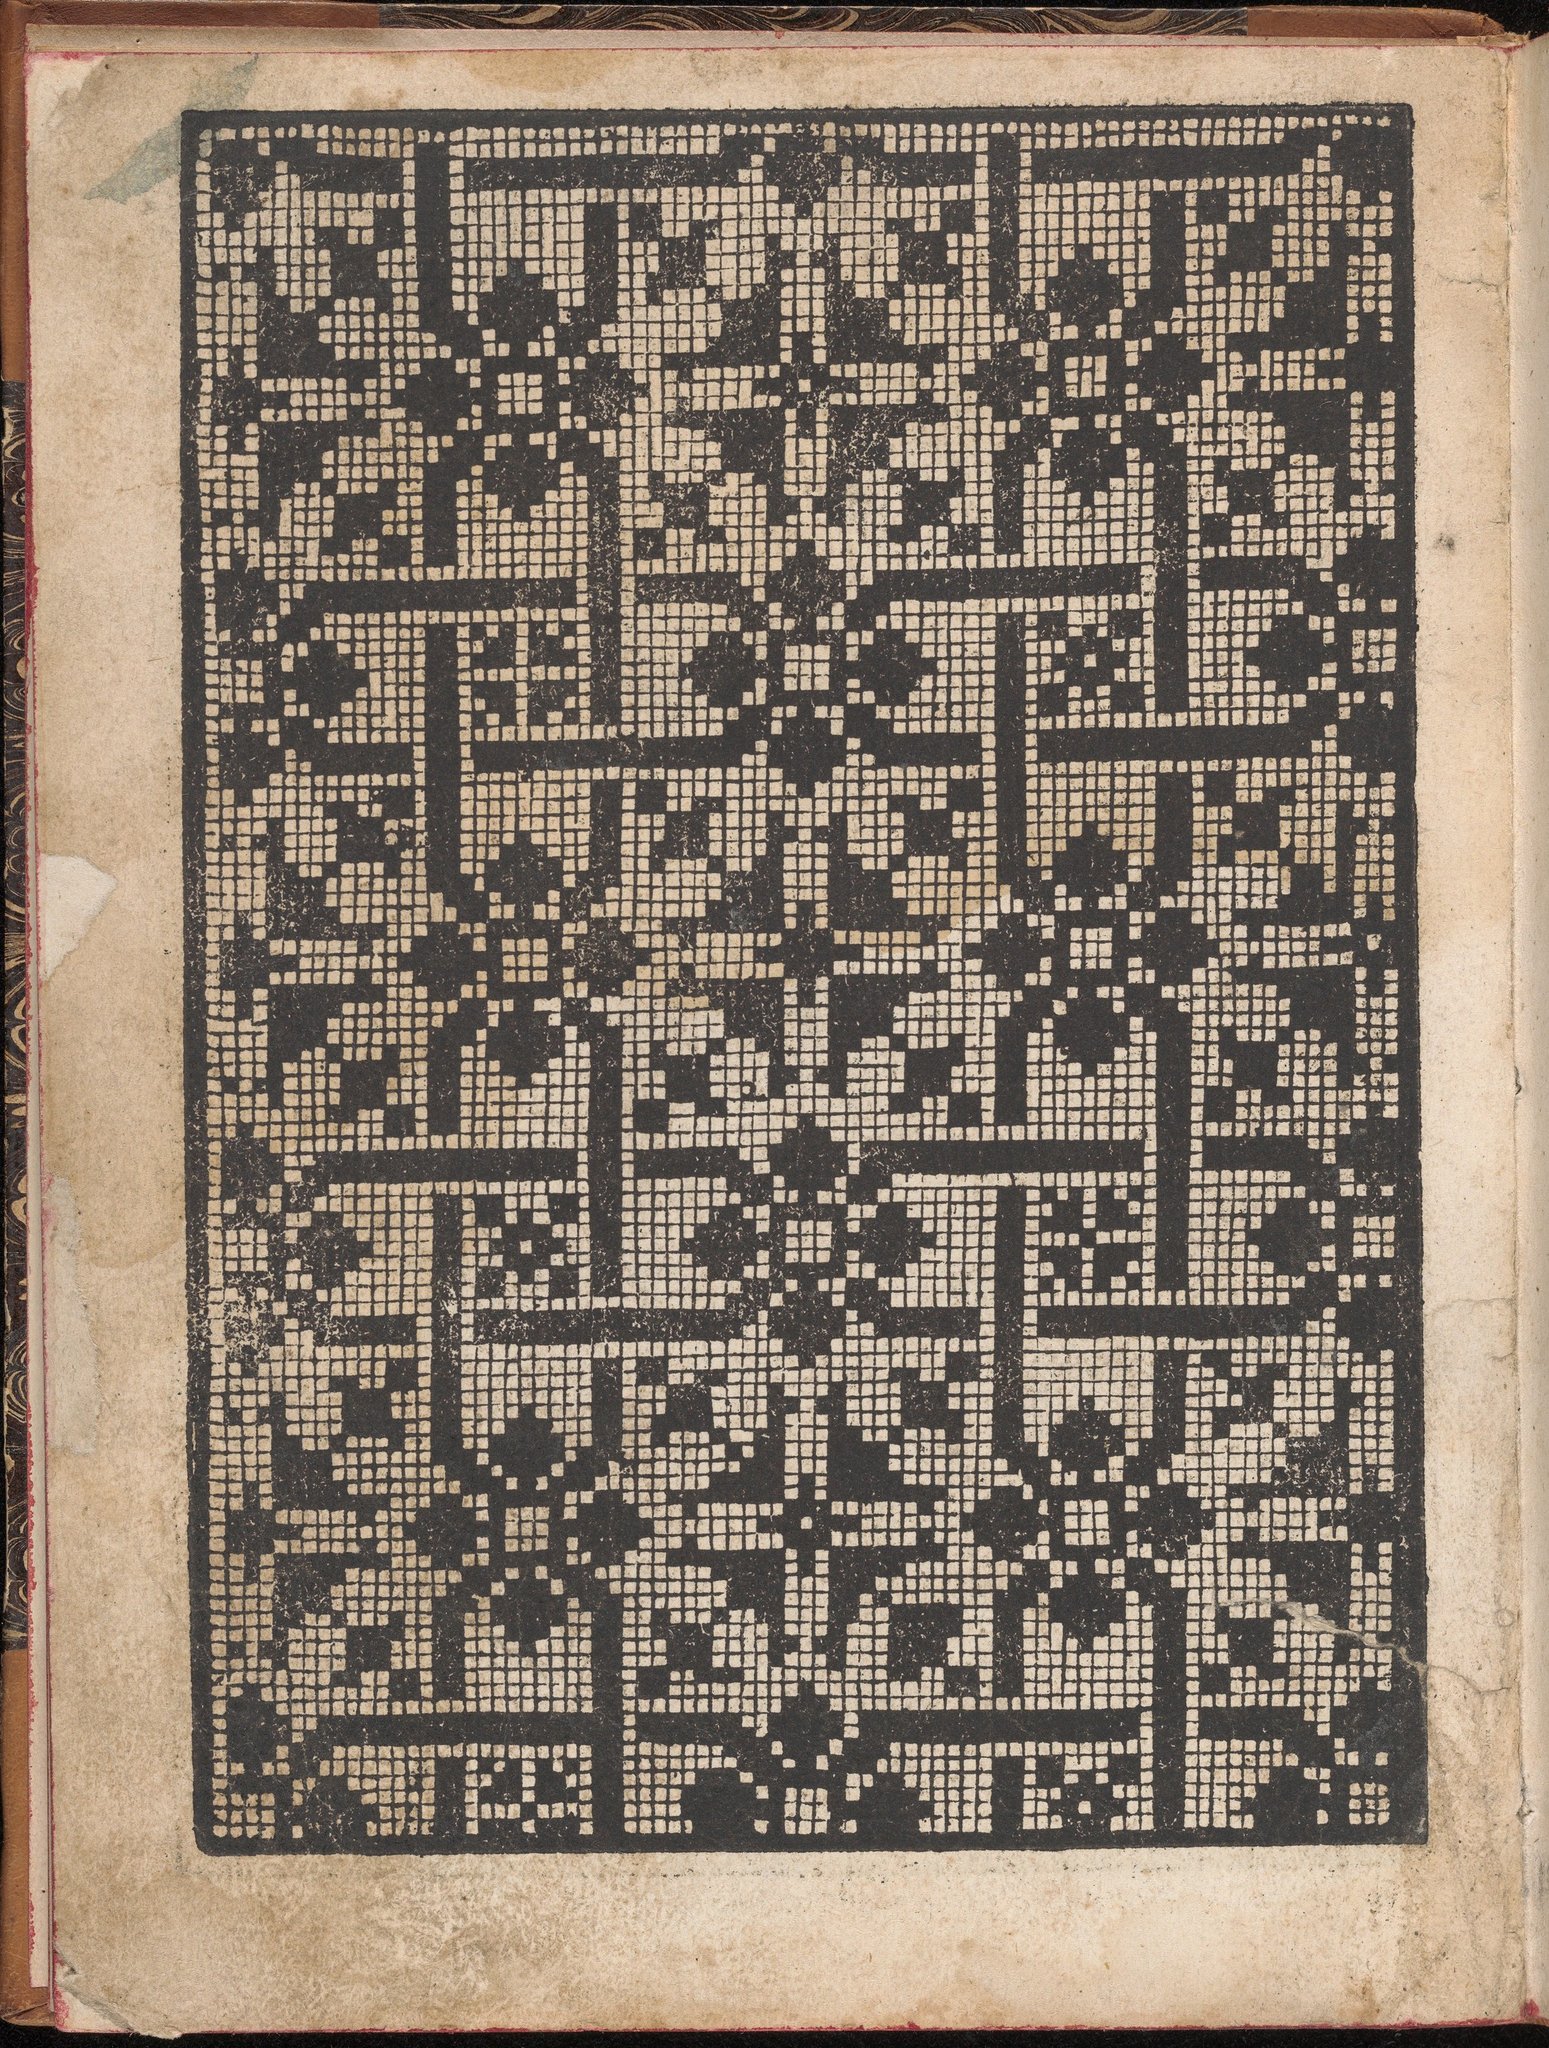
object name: book print ornament architecture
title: Spechio di pensieri delle belle et Virtudiose donne, page 13 (verso)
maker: matteo pagano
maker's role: publisher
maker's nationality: italian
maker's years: 1515-1588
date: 1546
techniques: woodcut